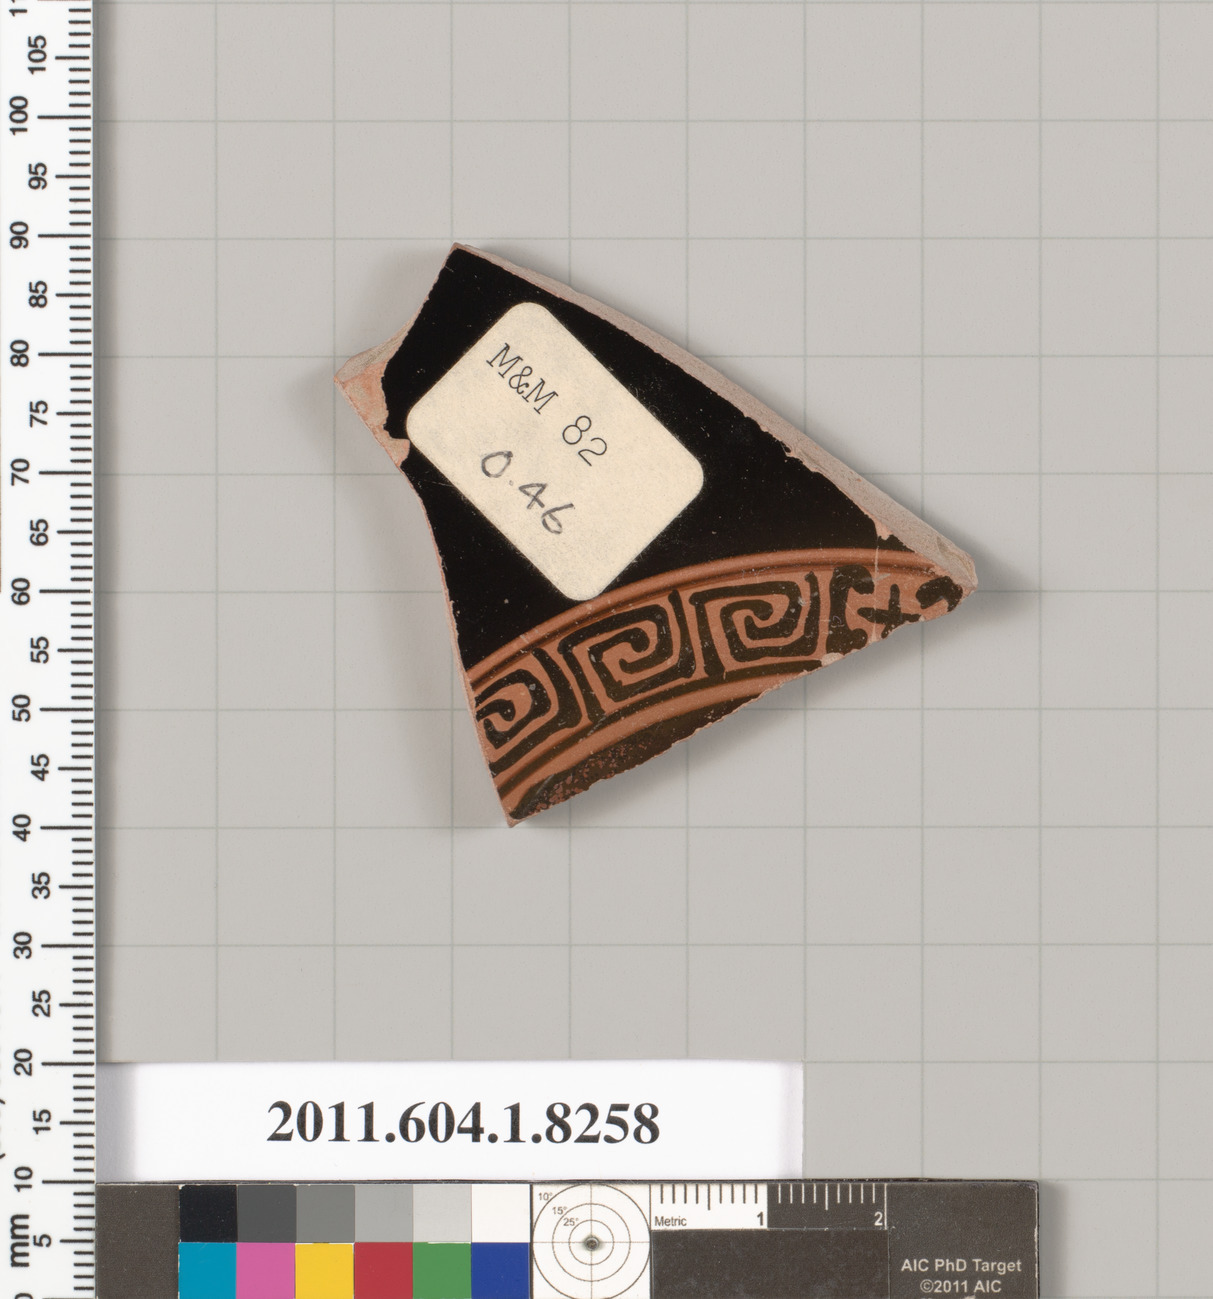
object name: kylix fragment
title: Terracotta fragment of a kylix (drinking cup)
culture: greek, attic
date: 475-451 BCE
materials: terracotta